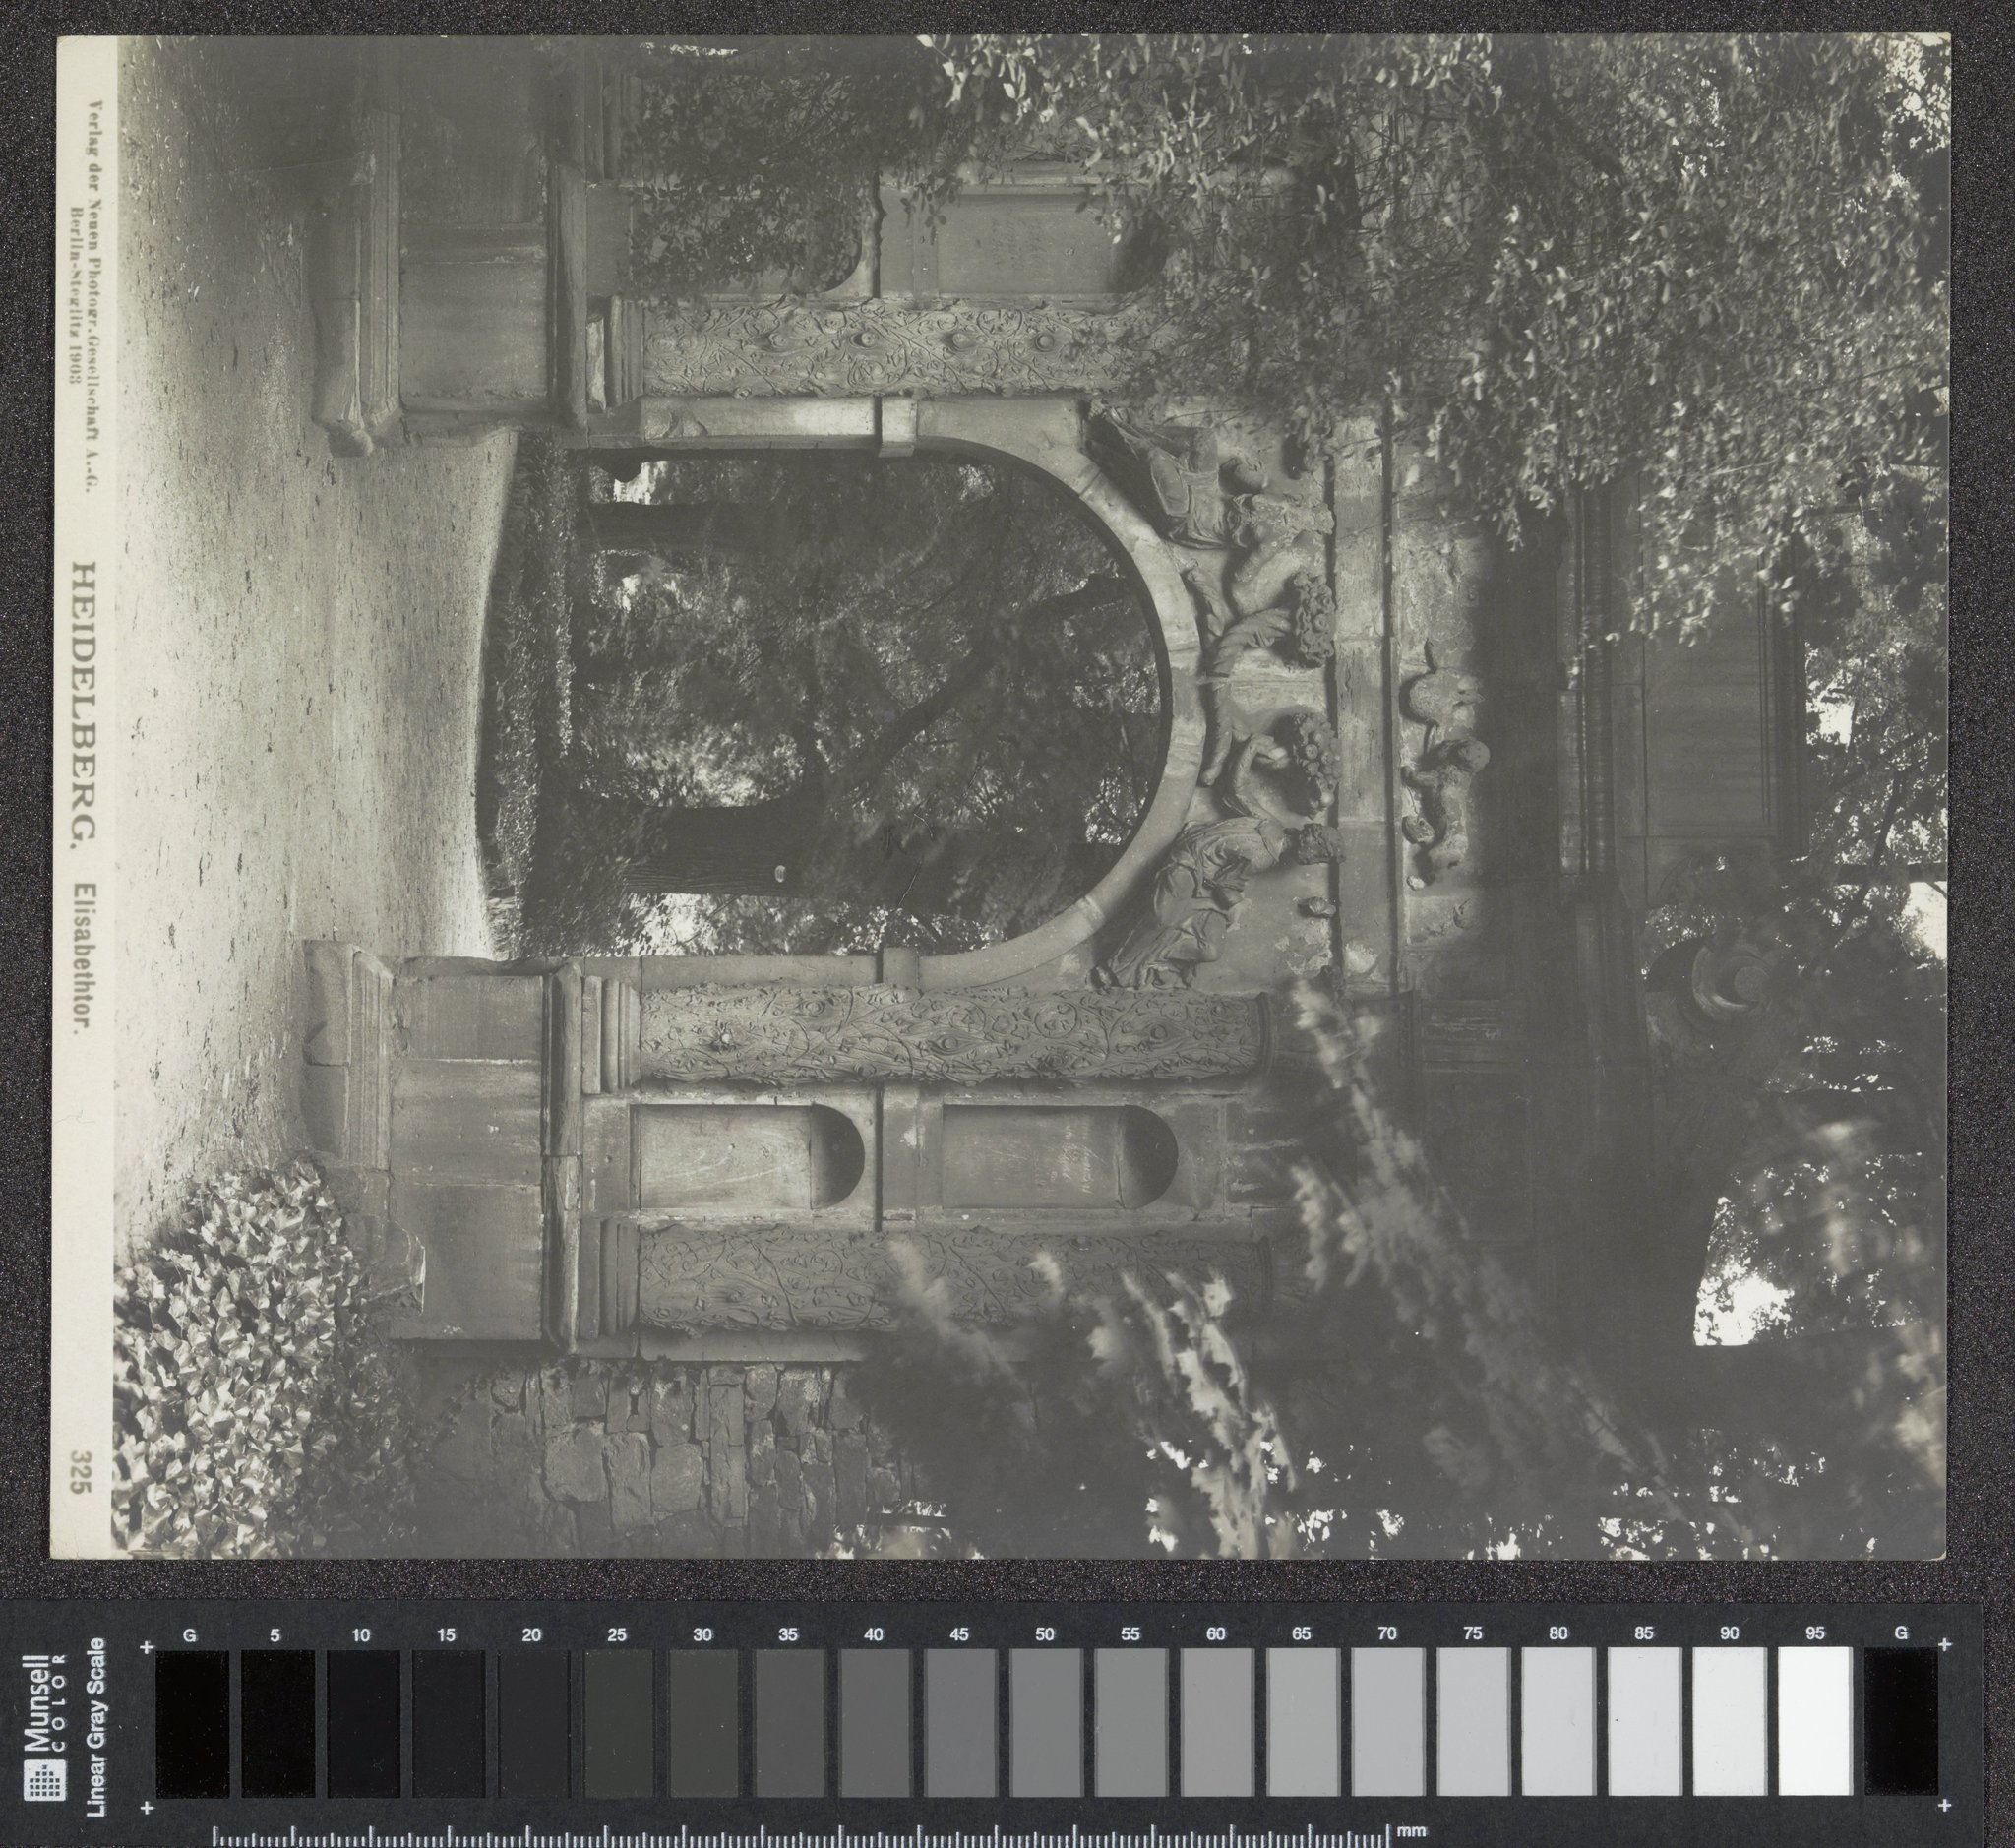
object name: photograph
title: Heidelberg. Elisabethtor.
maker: Anonymous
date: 1903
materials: photographic support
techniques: gelatin silver print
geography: heidelberg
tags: gate, entrance, public gardens, park, prospect of city, town panorama, silhouette of city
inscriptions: number: ‘325’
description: Onderdeel van Fotoalbum met opnames van Heidelberg en Schloss Heidelberg.